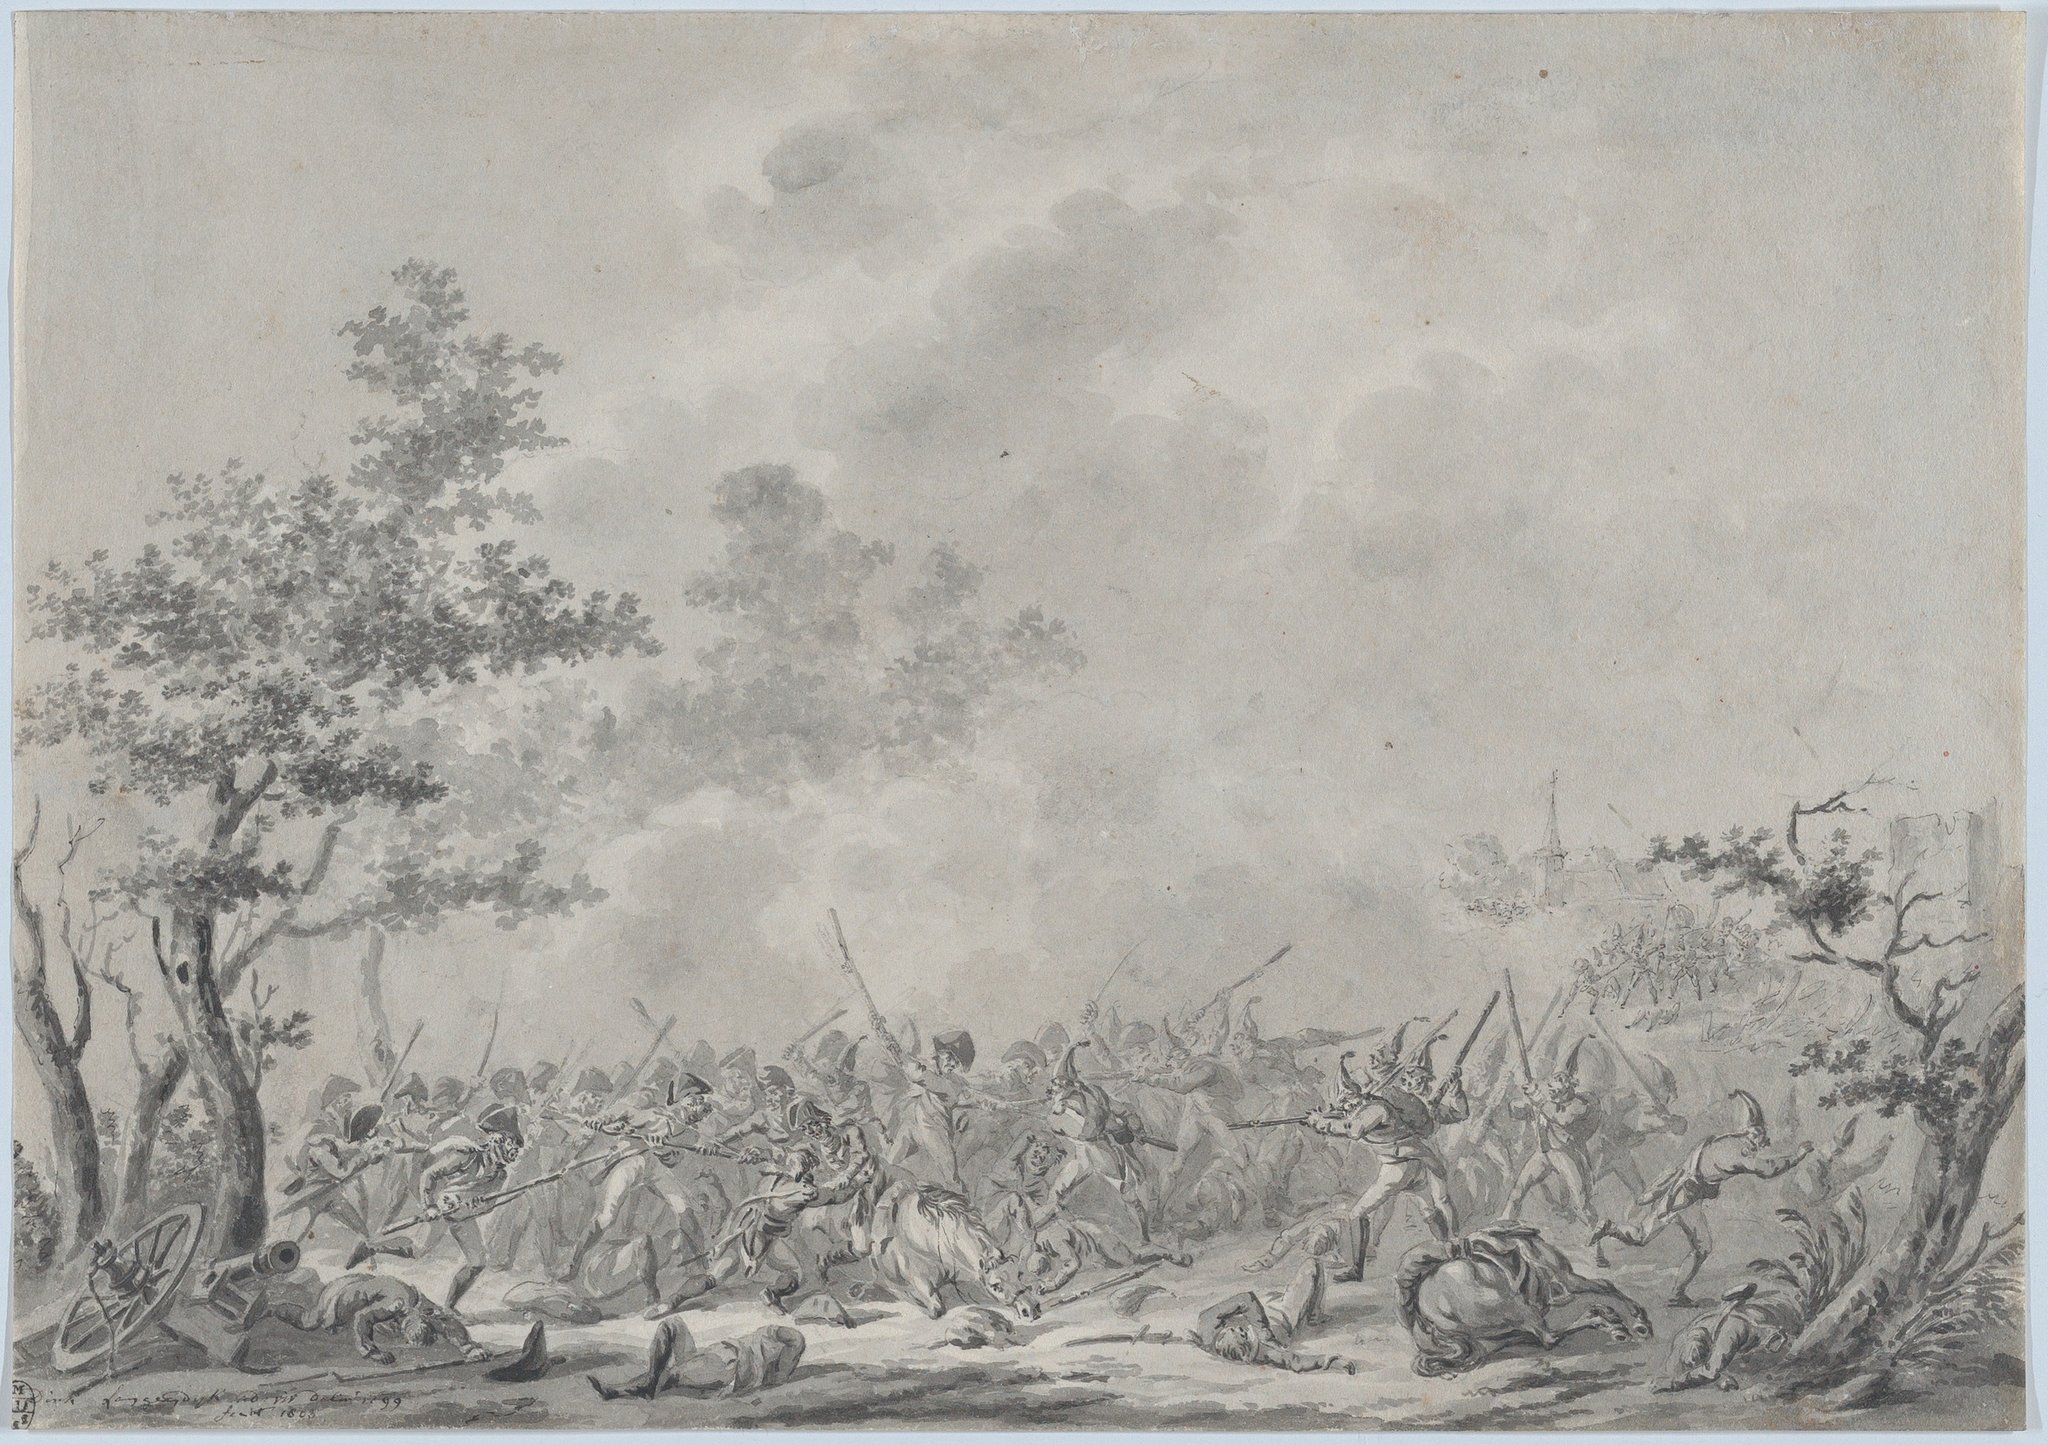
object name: drawing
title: The Capture of Lieutenant General Johann Hermann von Fersen During the Battle of Bergen (19 September 1799)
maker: dirk langendijk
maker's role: artist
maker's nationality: dutch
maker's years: 1748-1805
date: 1803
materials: ink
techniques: brush, pen, wash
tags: battles,soldiers,cannons,generals